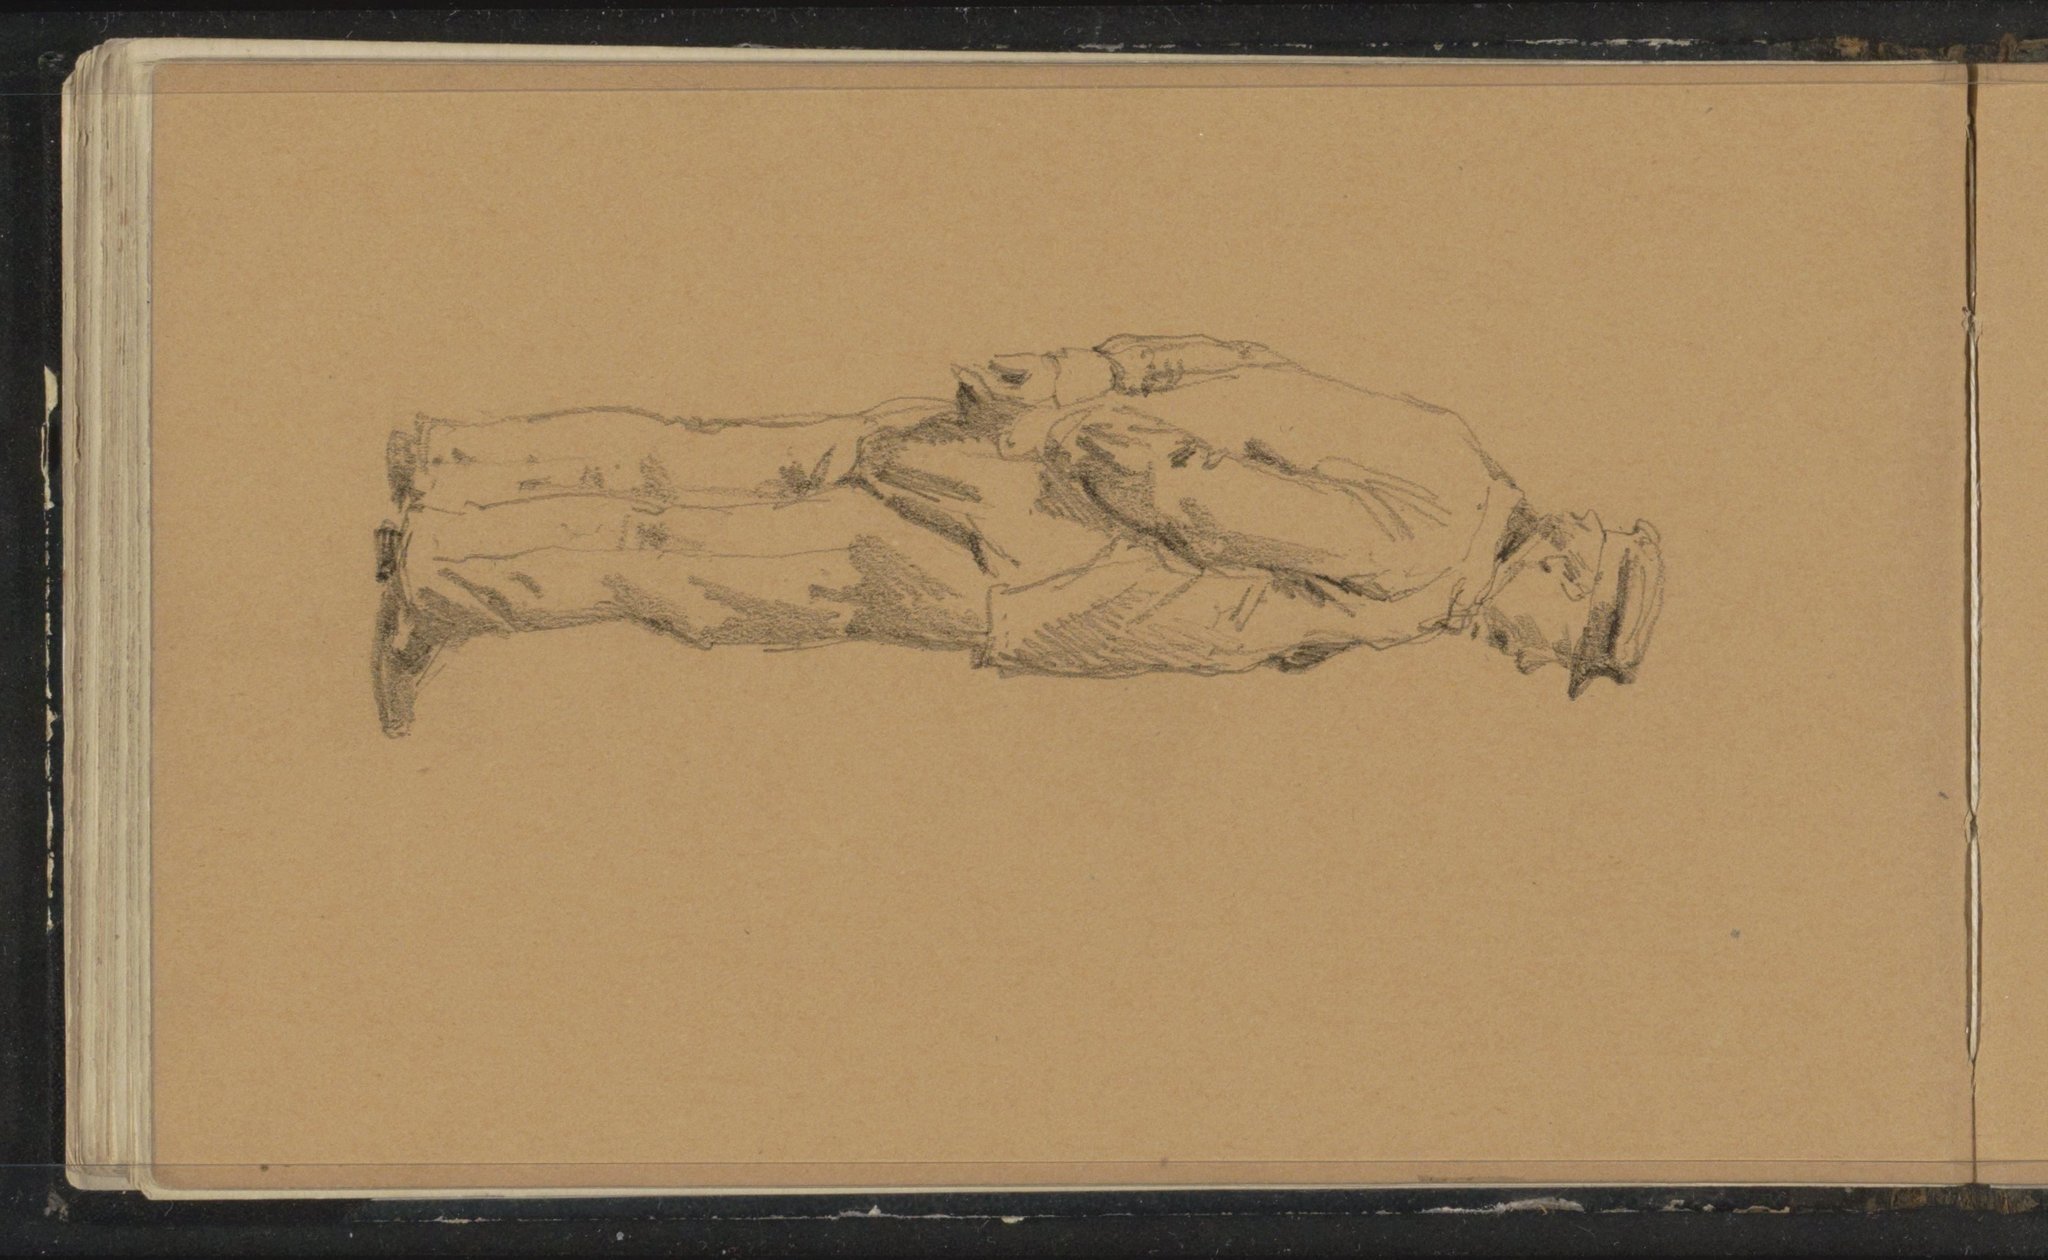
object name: sketchbook leaf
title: Staande man met pet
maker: cornelis springer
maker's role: draughtsman, painter, print maker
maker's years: 1817-1891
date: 1856-1861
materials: paper, pencil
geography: zeeland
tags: standing figure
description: Staande man met pet. Blad 34 verso uit een schetsboek met 44 bladen vervaardigd in Zeeland en Utrecht.